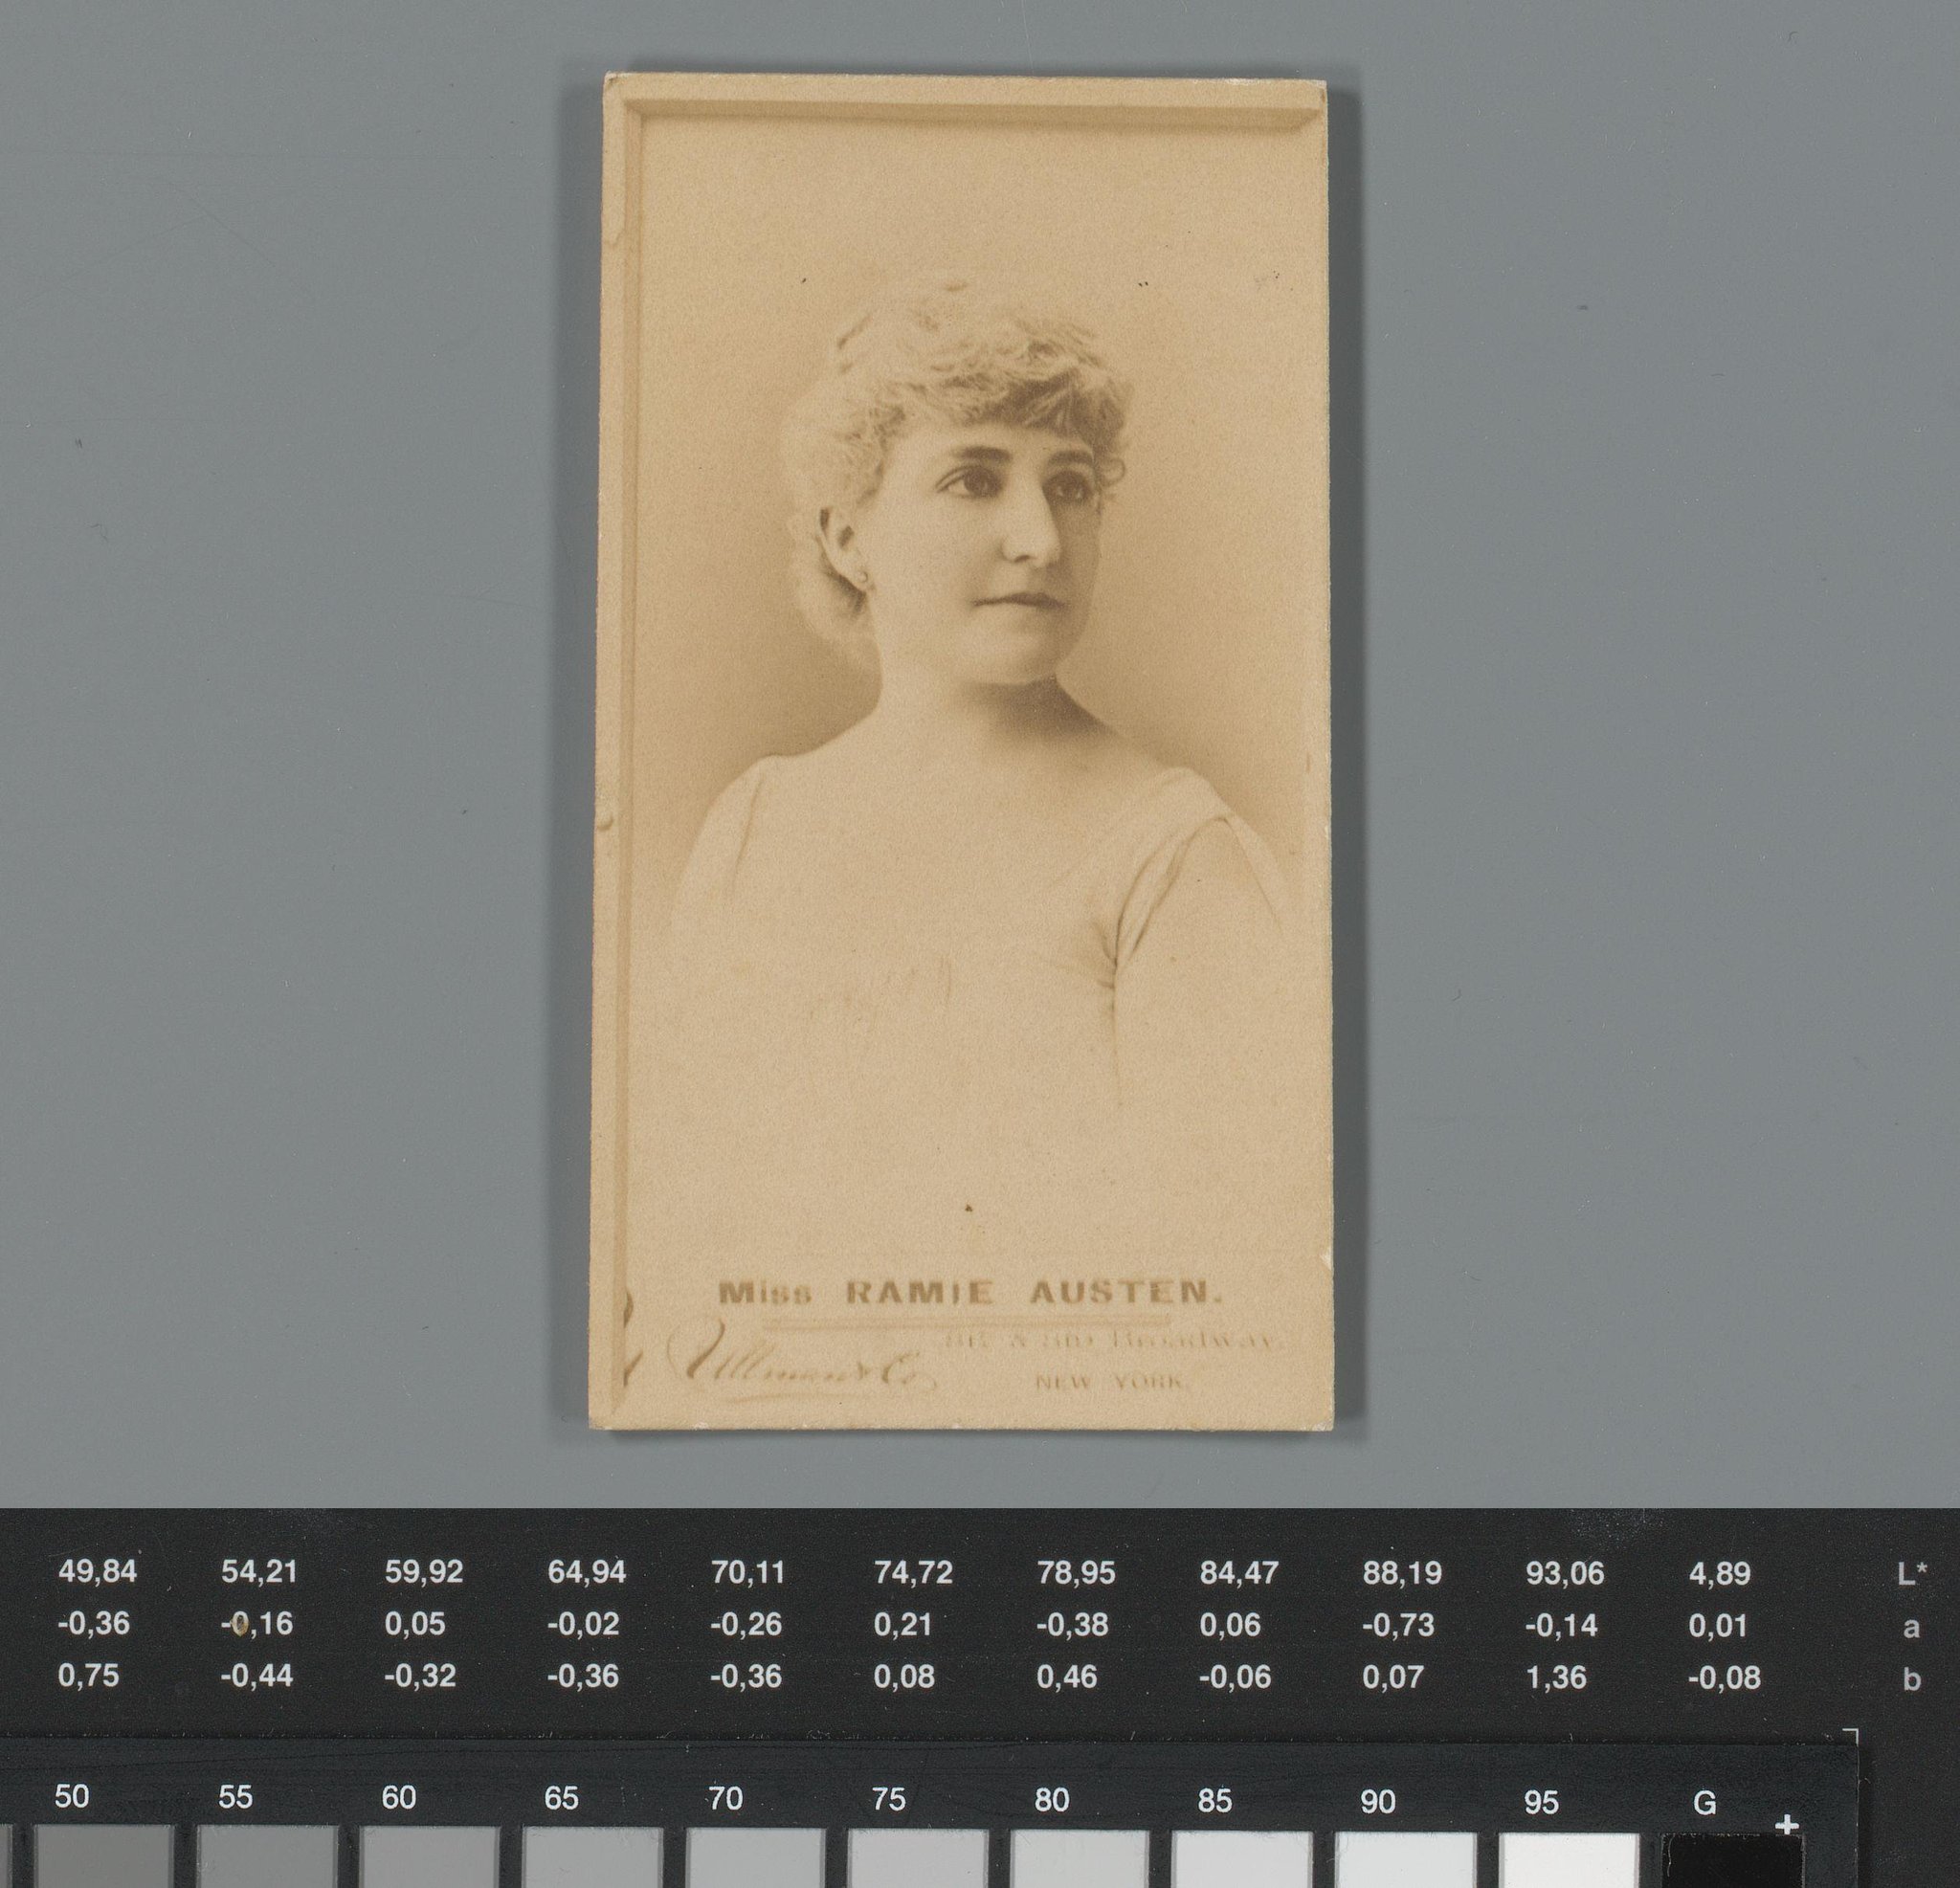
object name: photograph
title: Portret van Ramie Austen met reclame voor diens voorstelling 'Guilty without crime'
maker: Anonymous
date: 1850-1915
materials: cardboard, photographic support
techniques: albumen print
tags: advertising, historical persons - bb - woman, new york (city)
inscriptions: inscription: ‘(...)’